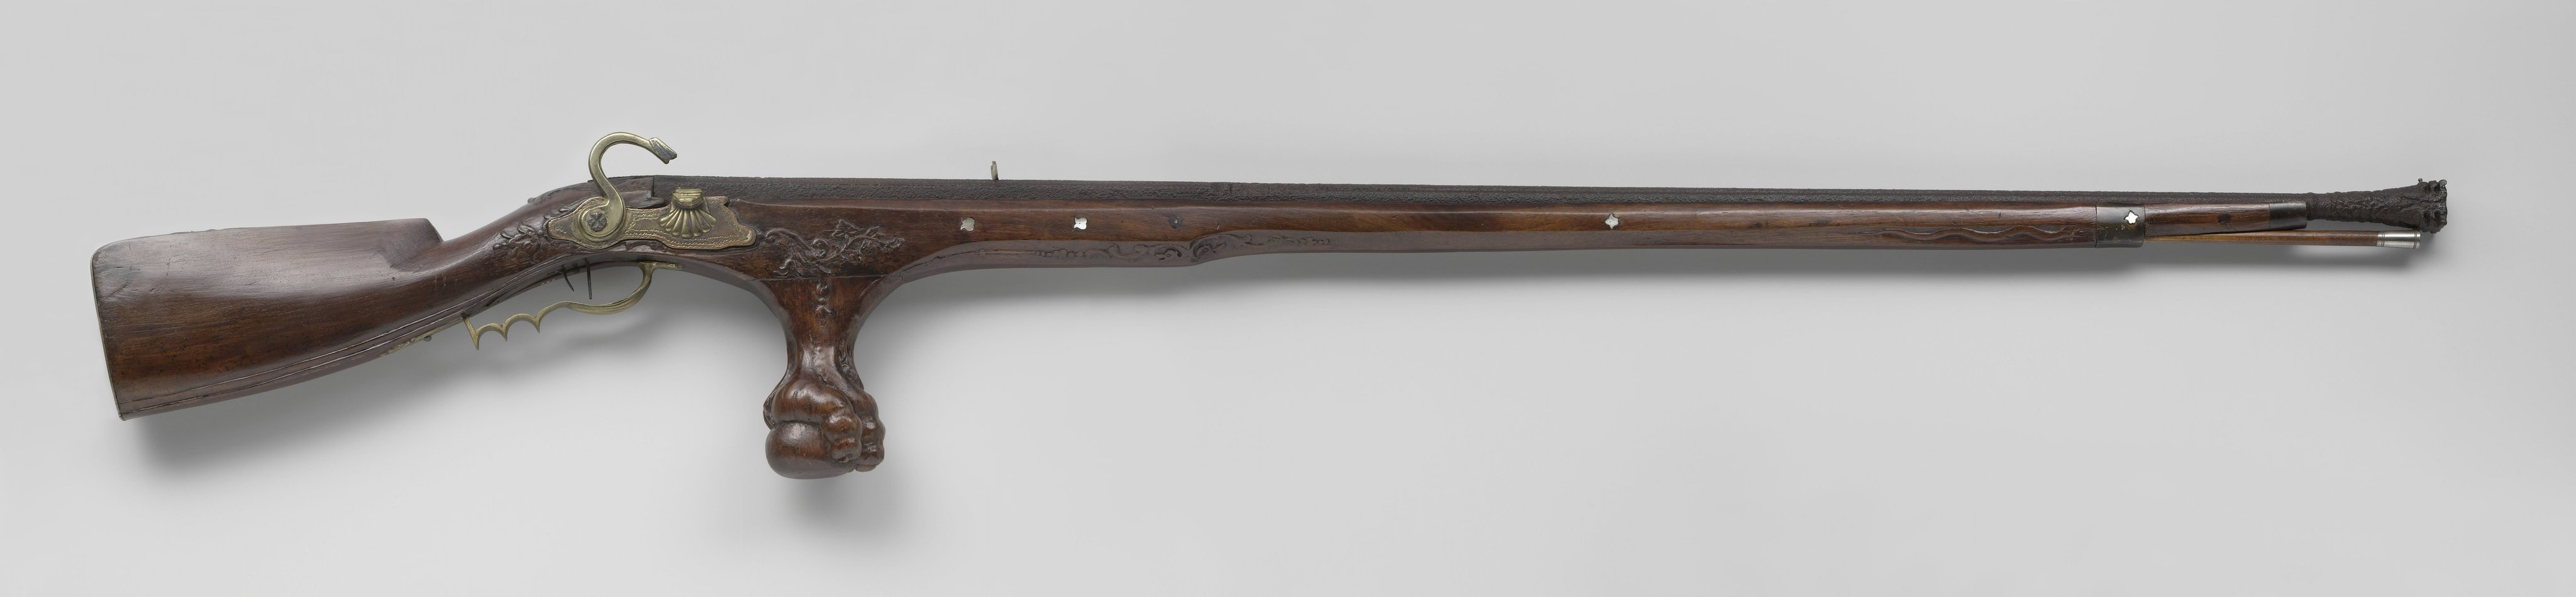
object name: target rifle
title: Target gun used by the Guild of Arquebusiers in Amsterdam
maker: jacobus jaspers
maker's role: geweermaker, pistoolmaker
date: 1675-1699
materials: brass, copper, horn, iron, mother of pearl, wood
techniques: cutting, engraving, gilding, inlay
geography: amsterdam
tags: birds (+ claws, paws of an animal), amsterdam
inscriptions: signature: ‘IACOBUS // IASPERS’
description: The support stand on this target gun is in the form of a taloned eagle’s claw grasping a ball, a reference to the Guild of Arquebusiers in Amsterdam. Civic guardsmen would grasp the support with their left hand, while pressing their left elbow into their side. The gun has a tinder lock, which uses a piece of smouldering dried fungus, rather than a slow match, to ignite the powder.